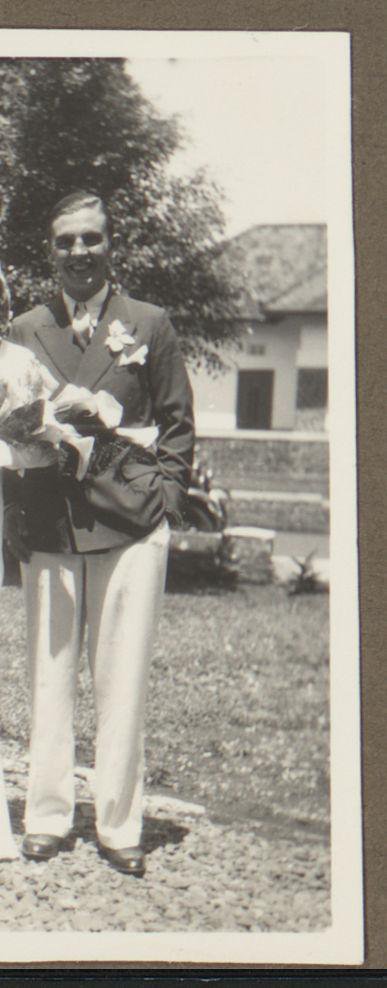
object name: photograph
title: Portret van Edward Burch en Ada Krüseman op hun bruiloft, Bandoeng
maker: Anonymous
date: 1932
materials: paper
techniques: gelatin silver print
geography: bandung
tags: historical persons, bride and groom in wedding-dress